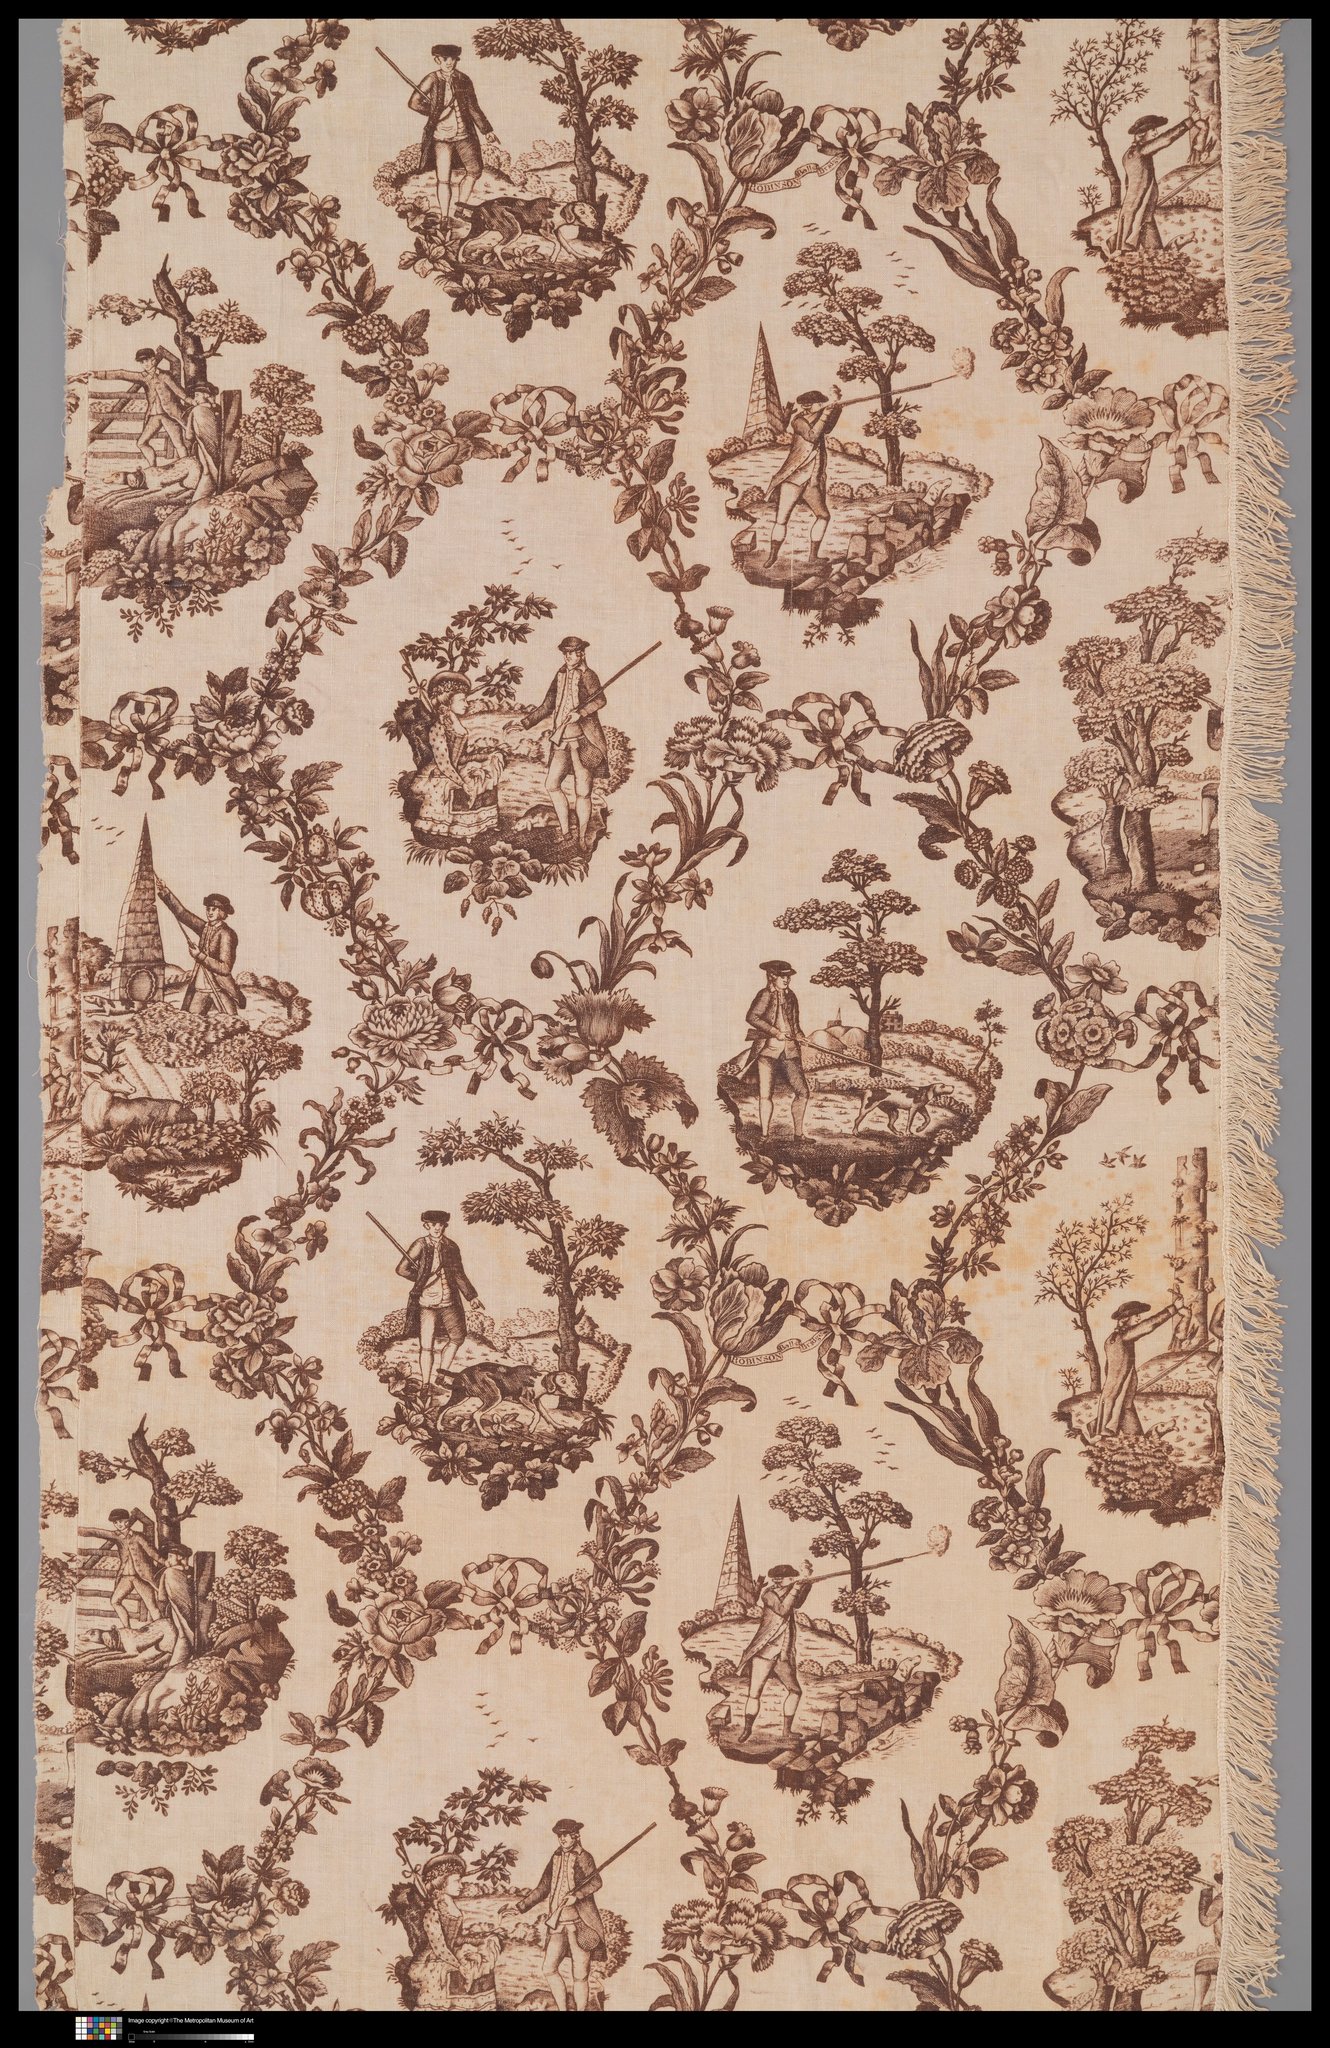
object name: bed curtain section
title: Section of bed curtain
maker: john robinson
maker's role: maker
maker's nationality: irish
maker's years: -1781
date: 1751-1800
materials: cotton, linen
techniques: printing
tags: men,hunting,deer,dogs